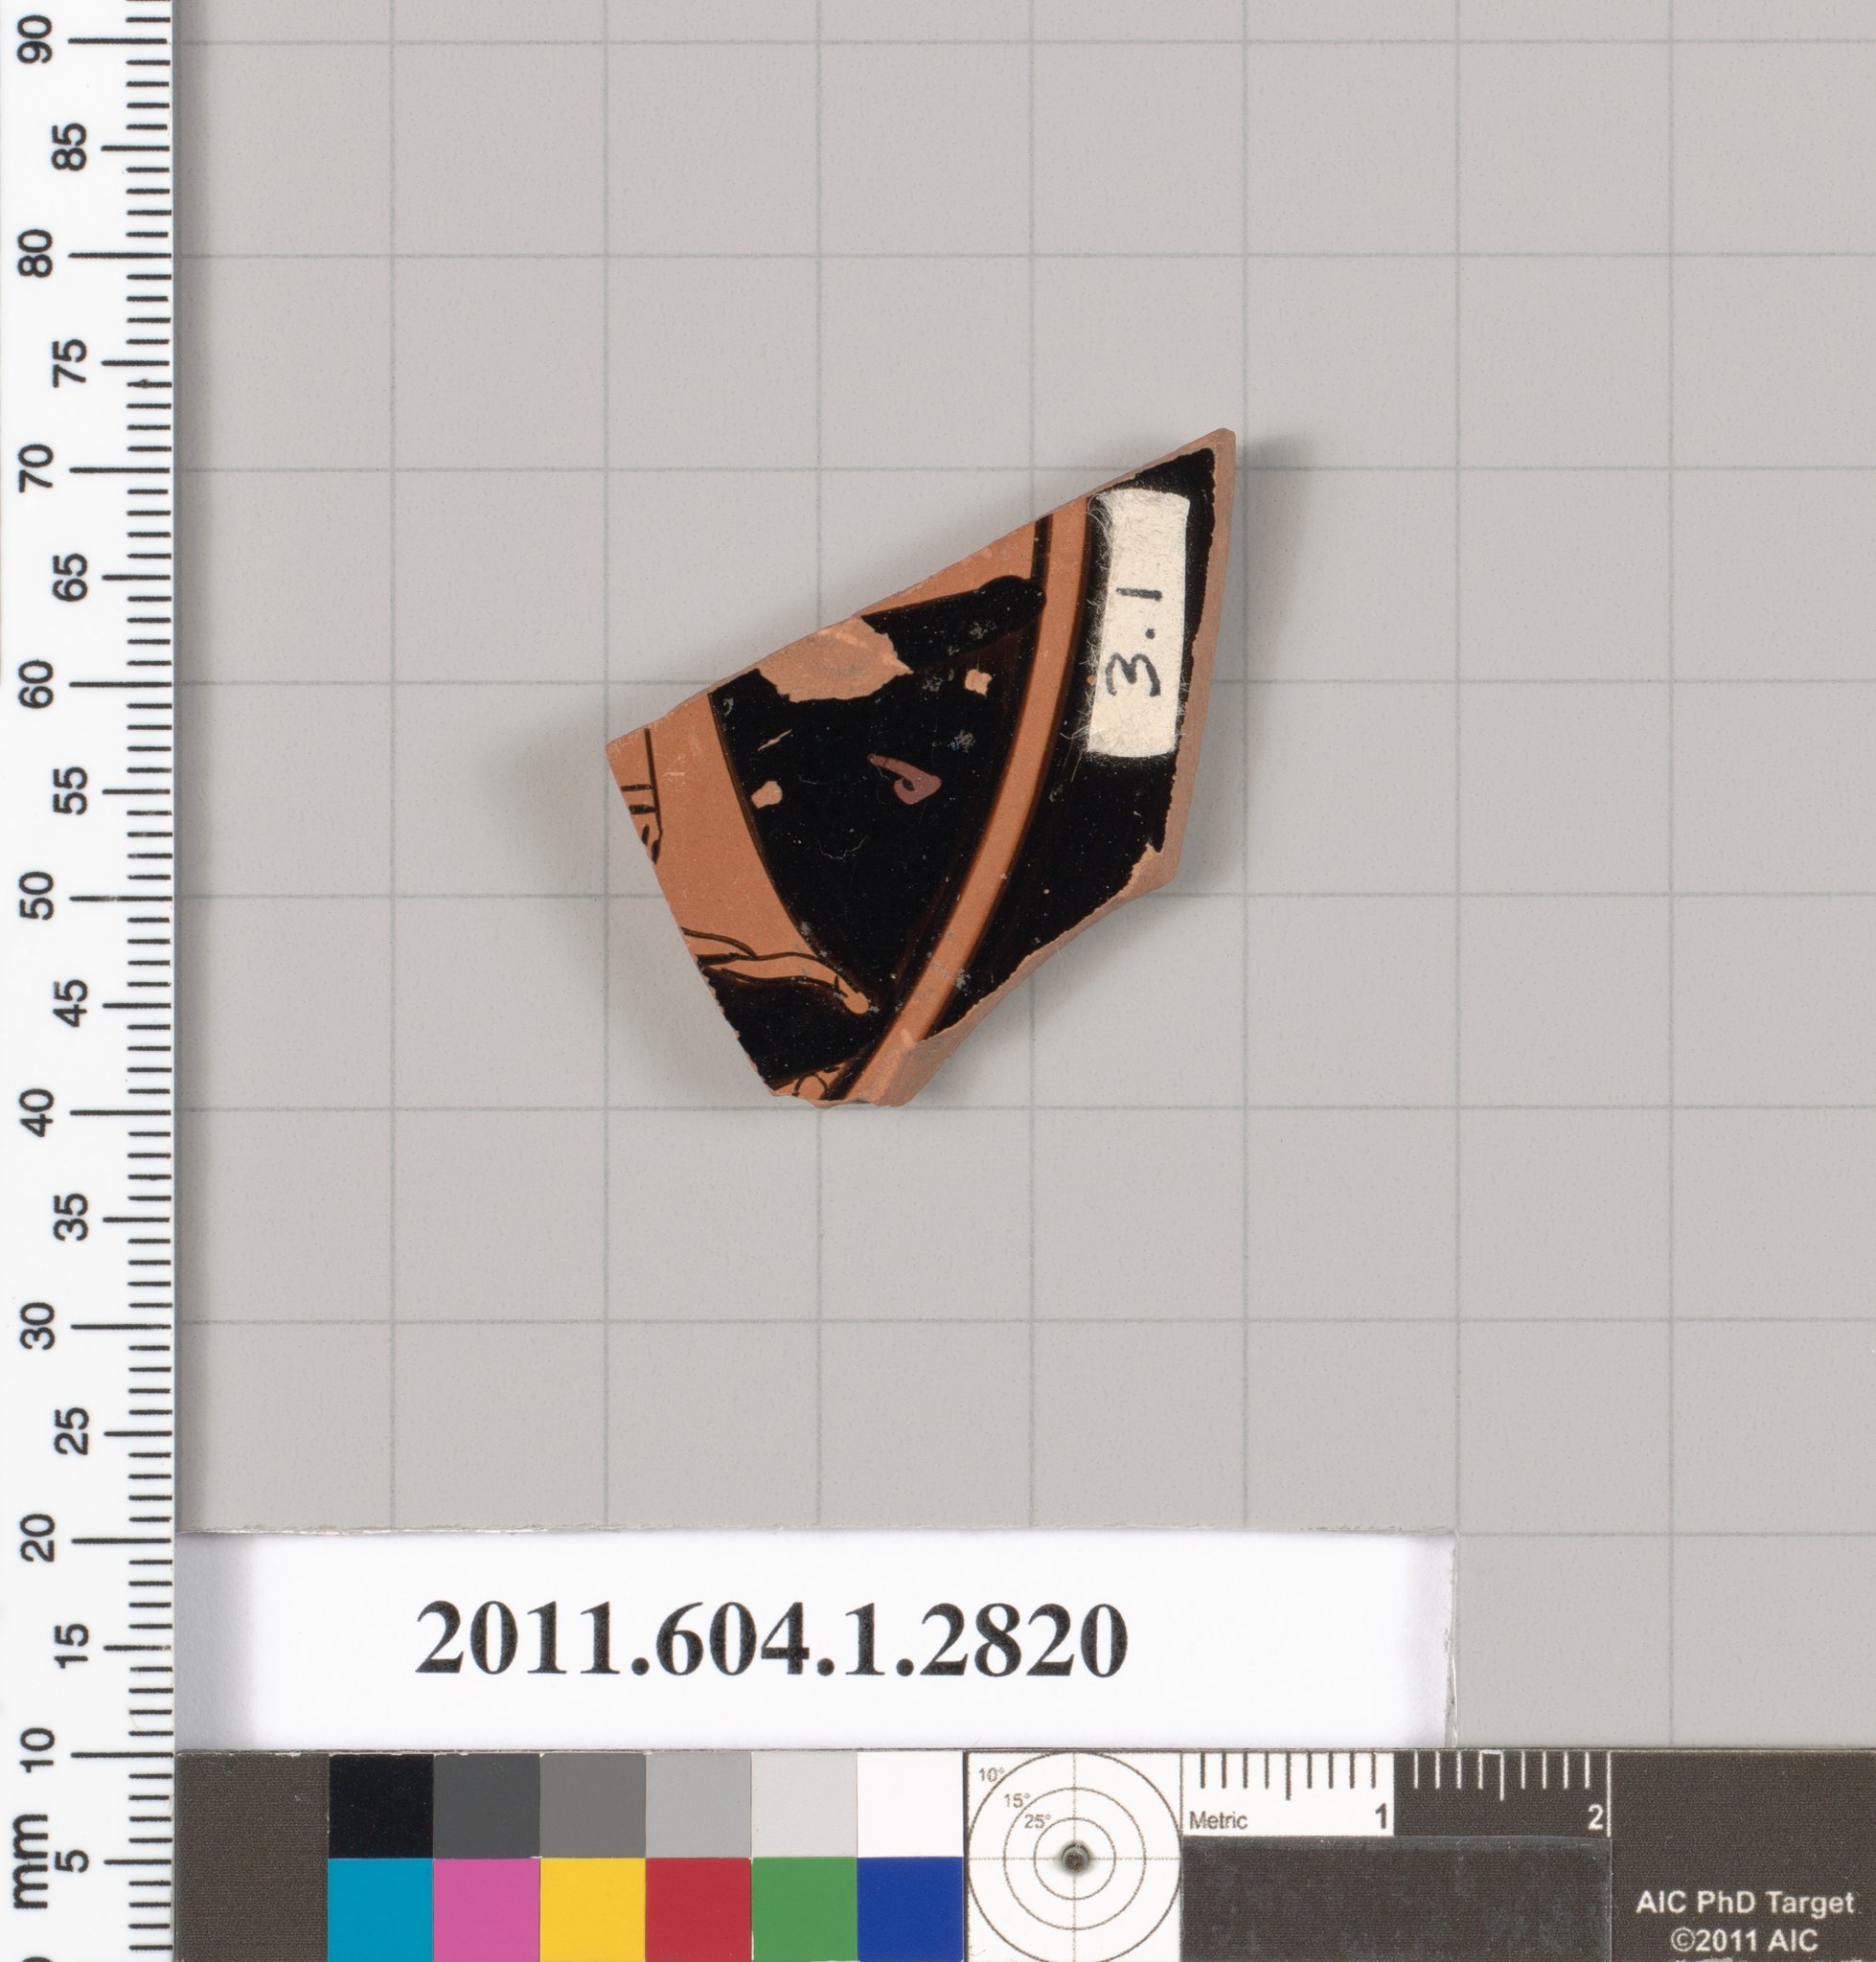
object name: kylix fragment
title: Terracotta fragment of a kylix (drinking cup)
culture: greek, attic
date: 520-500 BCE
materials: terracotta